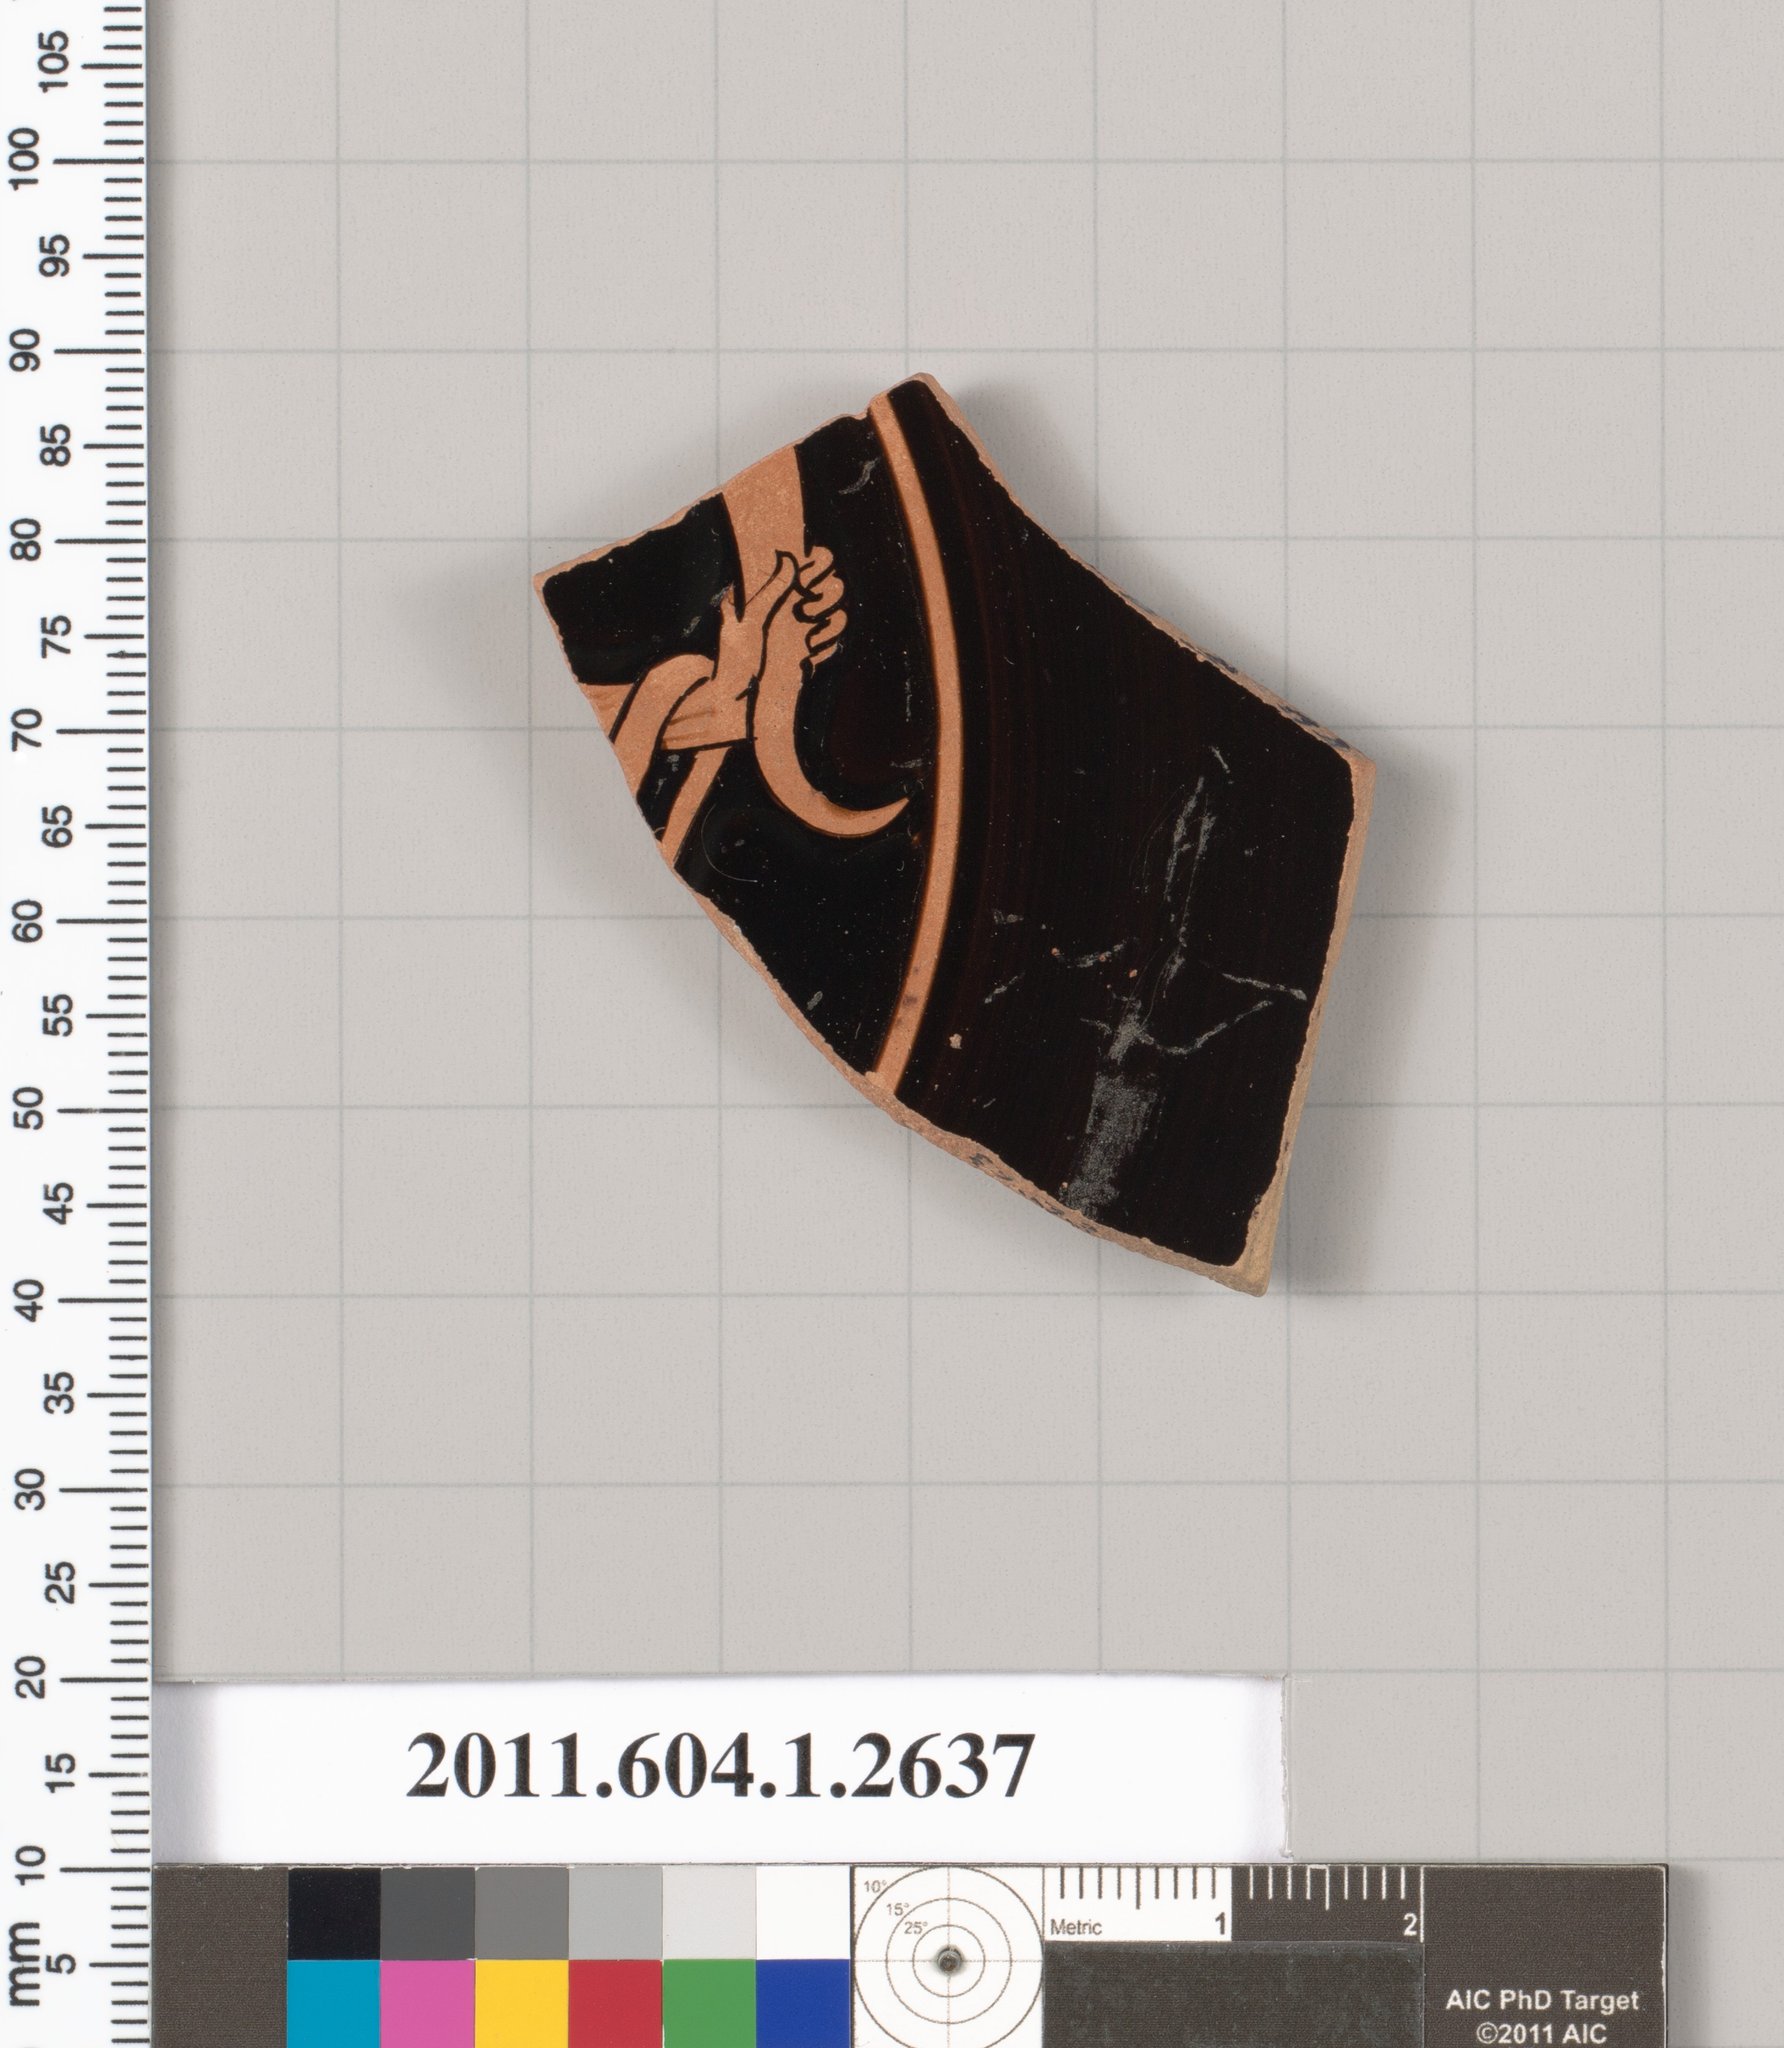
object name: kylix fragment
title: Terracotta fragment of a kylix (drinking cup)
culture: greek, attic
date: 520-500 BCE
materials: terracotta